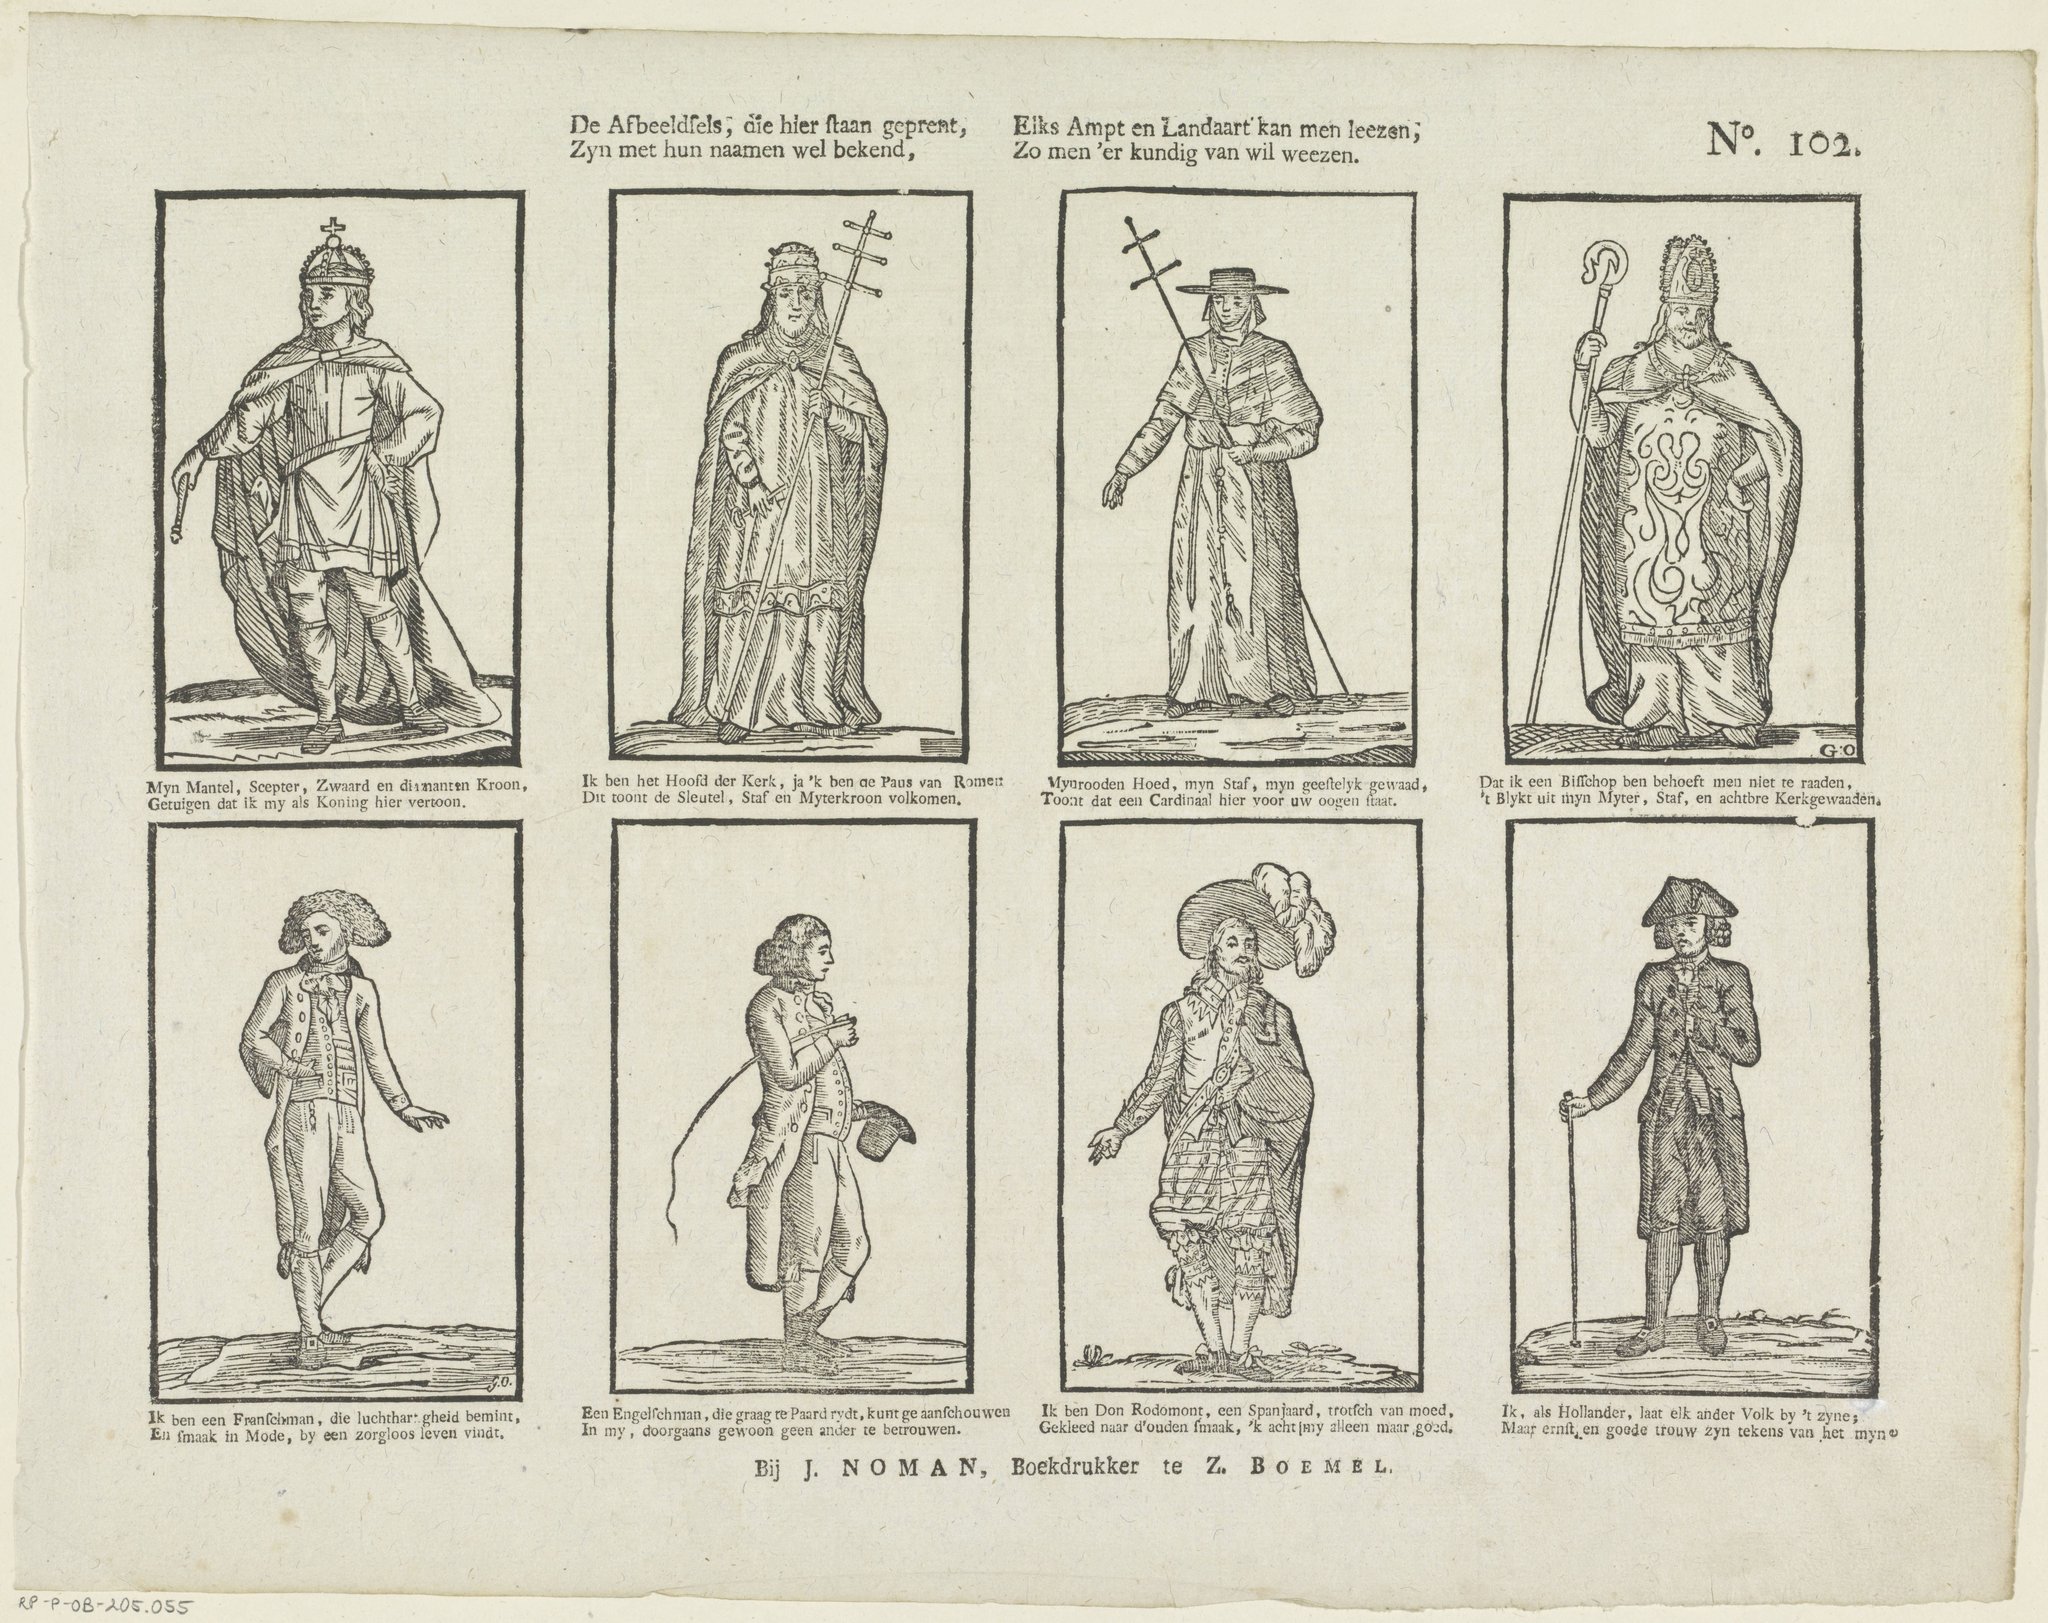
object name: print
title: De afbeeldsels, die hier staan geprent, / Zyn met hun naamen wel bekend, / Elks ampt en landaart kan met leezen; / Zo men 'r er kundig van wil weezen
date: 1806-1830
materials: paper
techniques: letterpress printing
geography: netherlands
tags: europeans, archbishop, bishop, etc. (roman catholic), cardinal, ruler, sovereign, pope, france, holland, spain, england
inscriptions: collector's mark: Lugt 2760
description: Blad met 8 voorstellingen van een koning, een paus, een kardinaal, een bisschop, een Fransman, een Engelsman, een Spanjaard en een Hollander. Onder elke afbeelding een tweeregelig vers. Genummerd rechtsboven: No. 102.